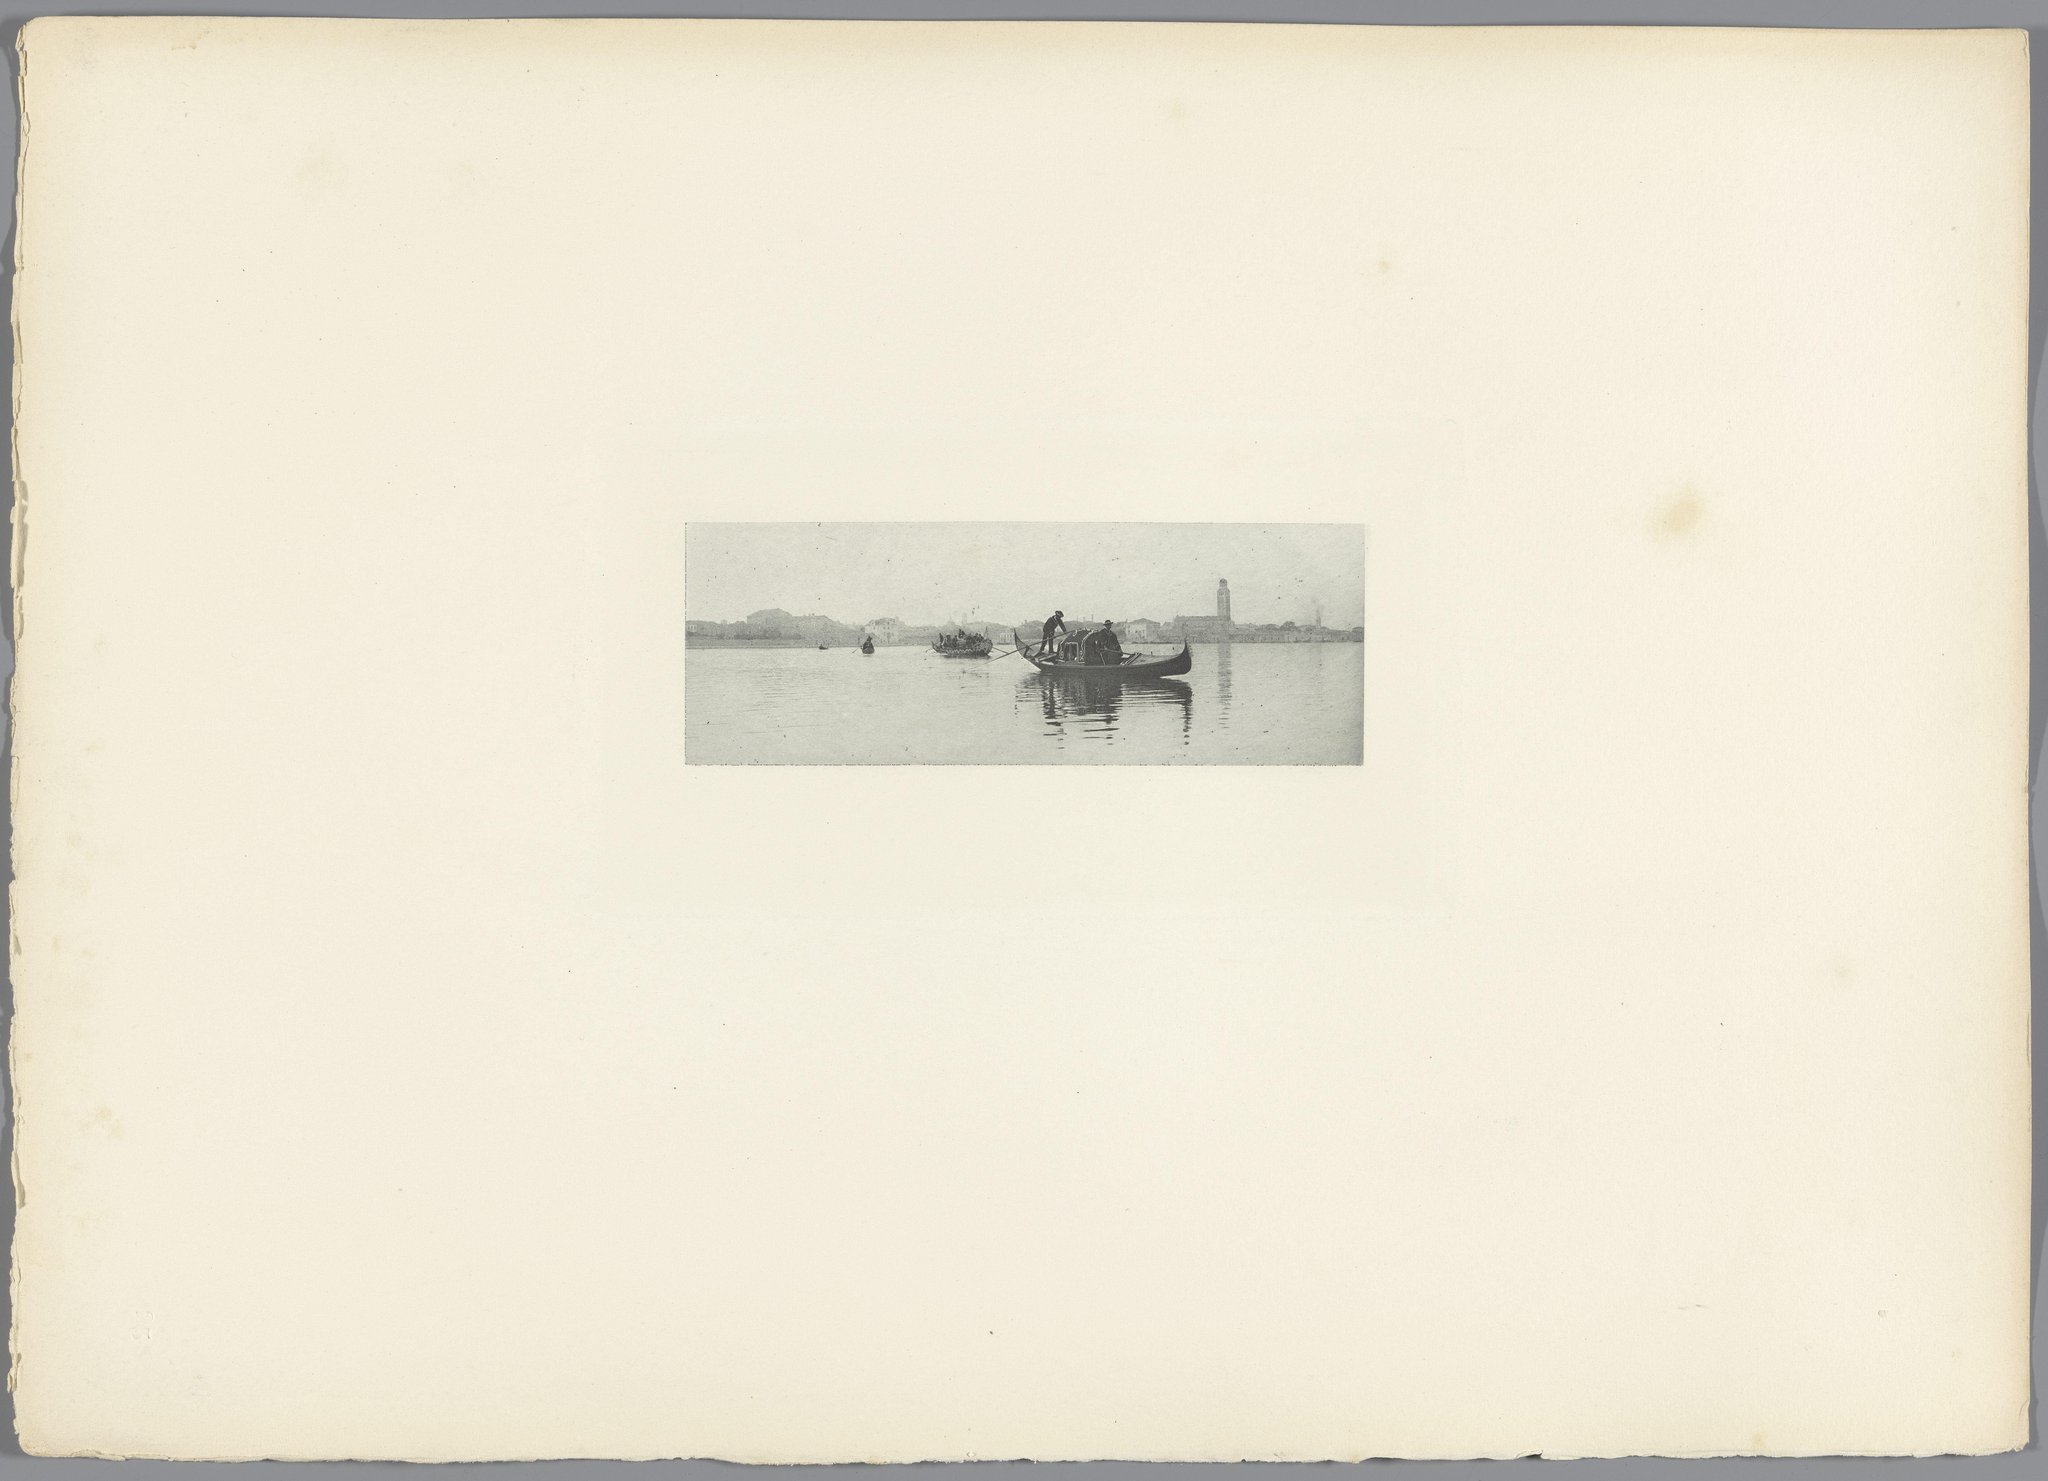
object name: photomechanical print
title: Un enterrement à Venise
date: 1891-1896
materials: paper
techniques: photoaquatint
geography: venice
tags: city-view in general; 'veduta', cortege, funeral procession, gondola, venice